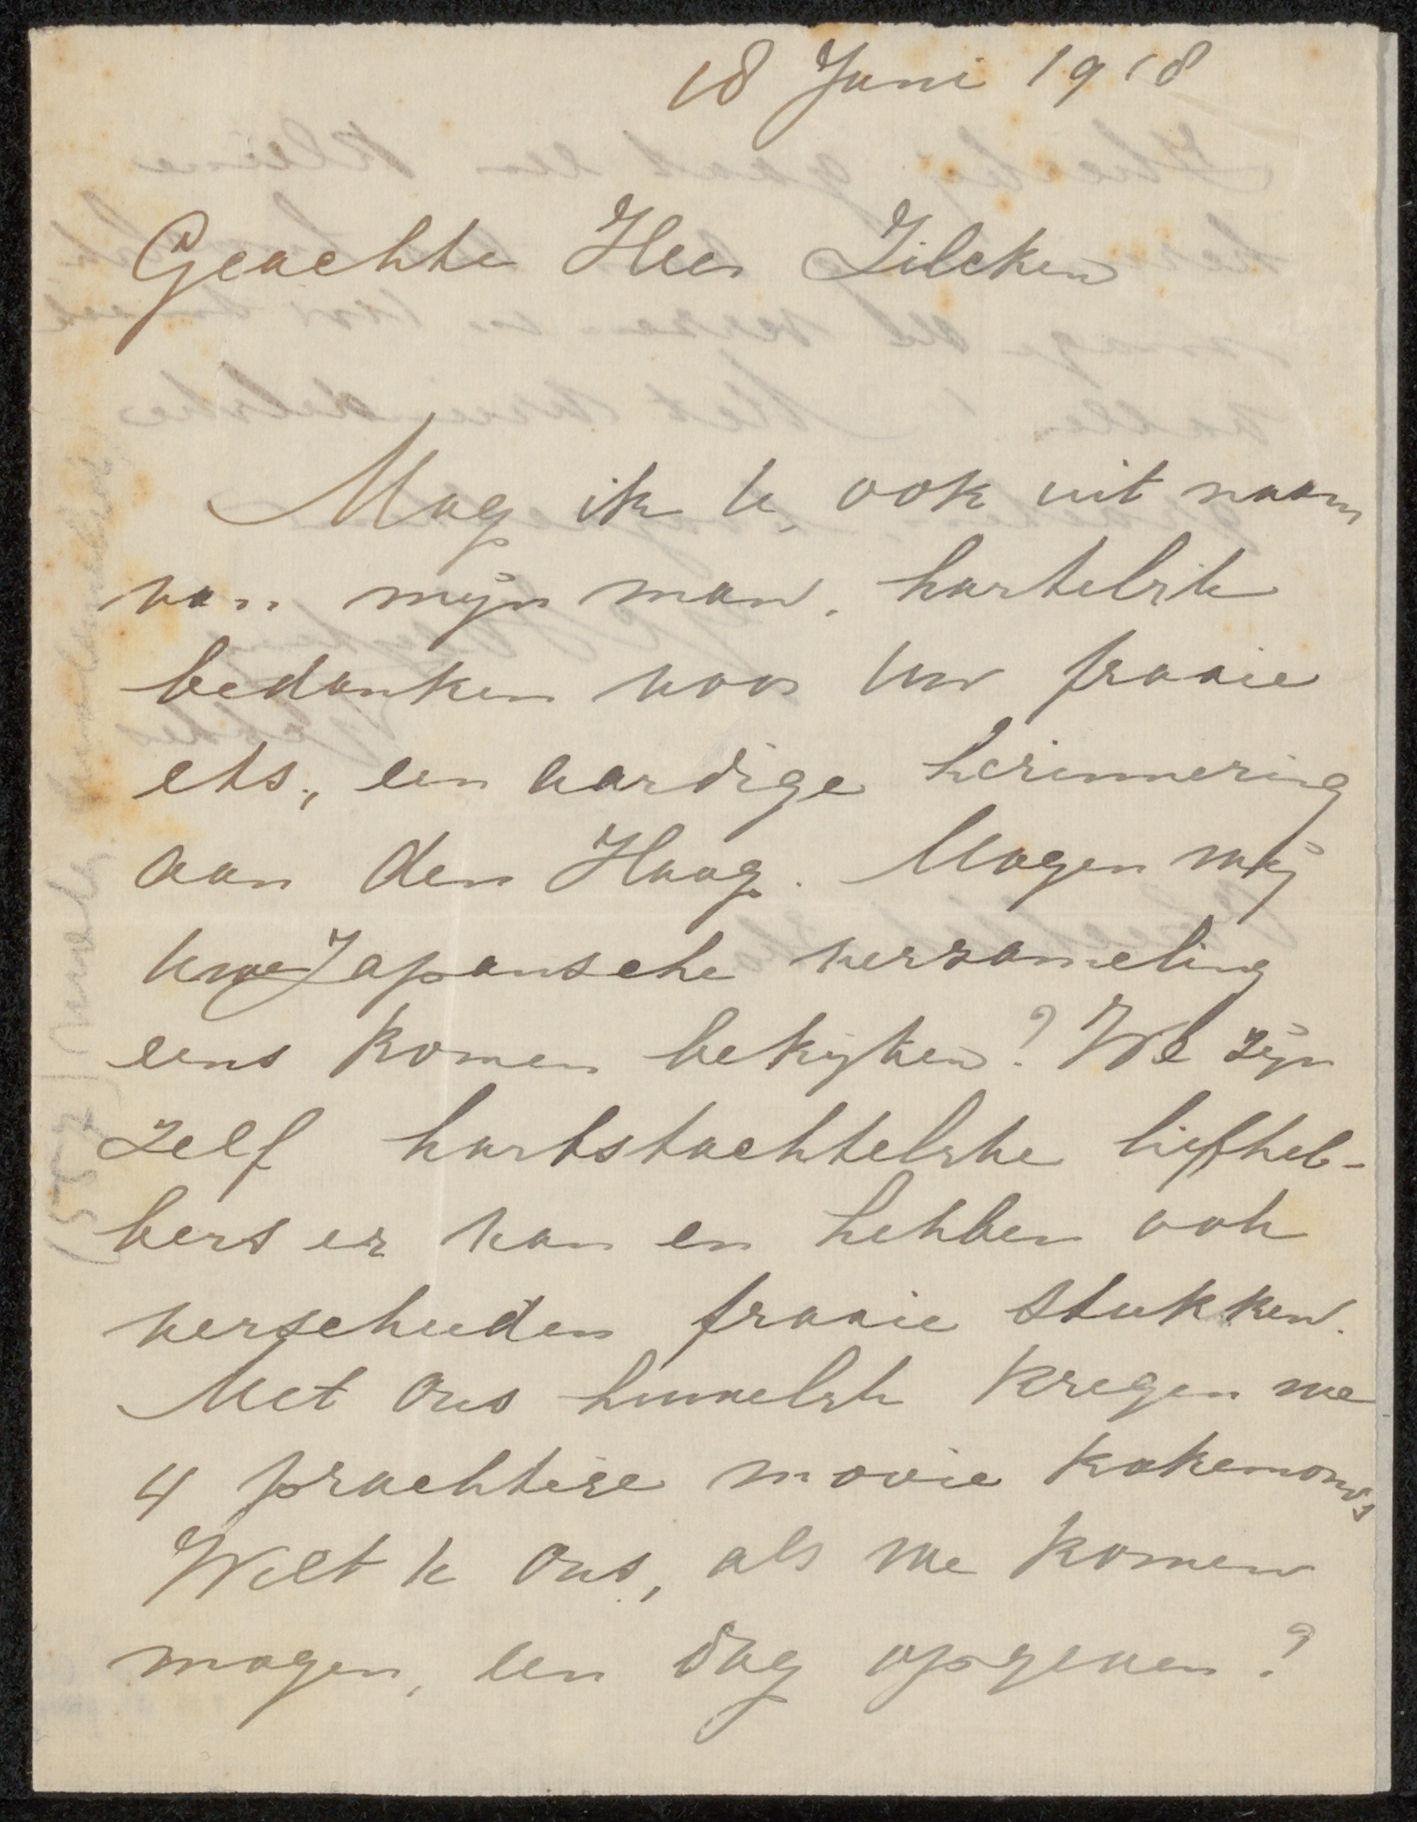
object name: letter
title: Brief aan Philip Zilcken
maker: annie heyting-tjebbes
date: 1918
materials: ink, paper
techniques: pen, writing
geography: the hague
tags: august heyting, draughtsman, philip zilcken, the graphic arts, family life, the hague, japan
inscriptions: collector's mark: ‘RPK’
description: Samen met deze brief is een vel met twee gedichten door August Heyting (RP-D-1982-43-HEYTING(A.)-DOC.2) verstuurd.